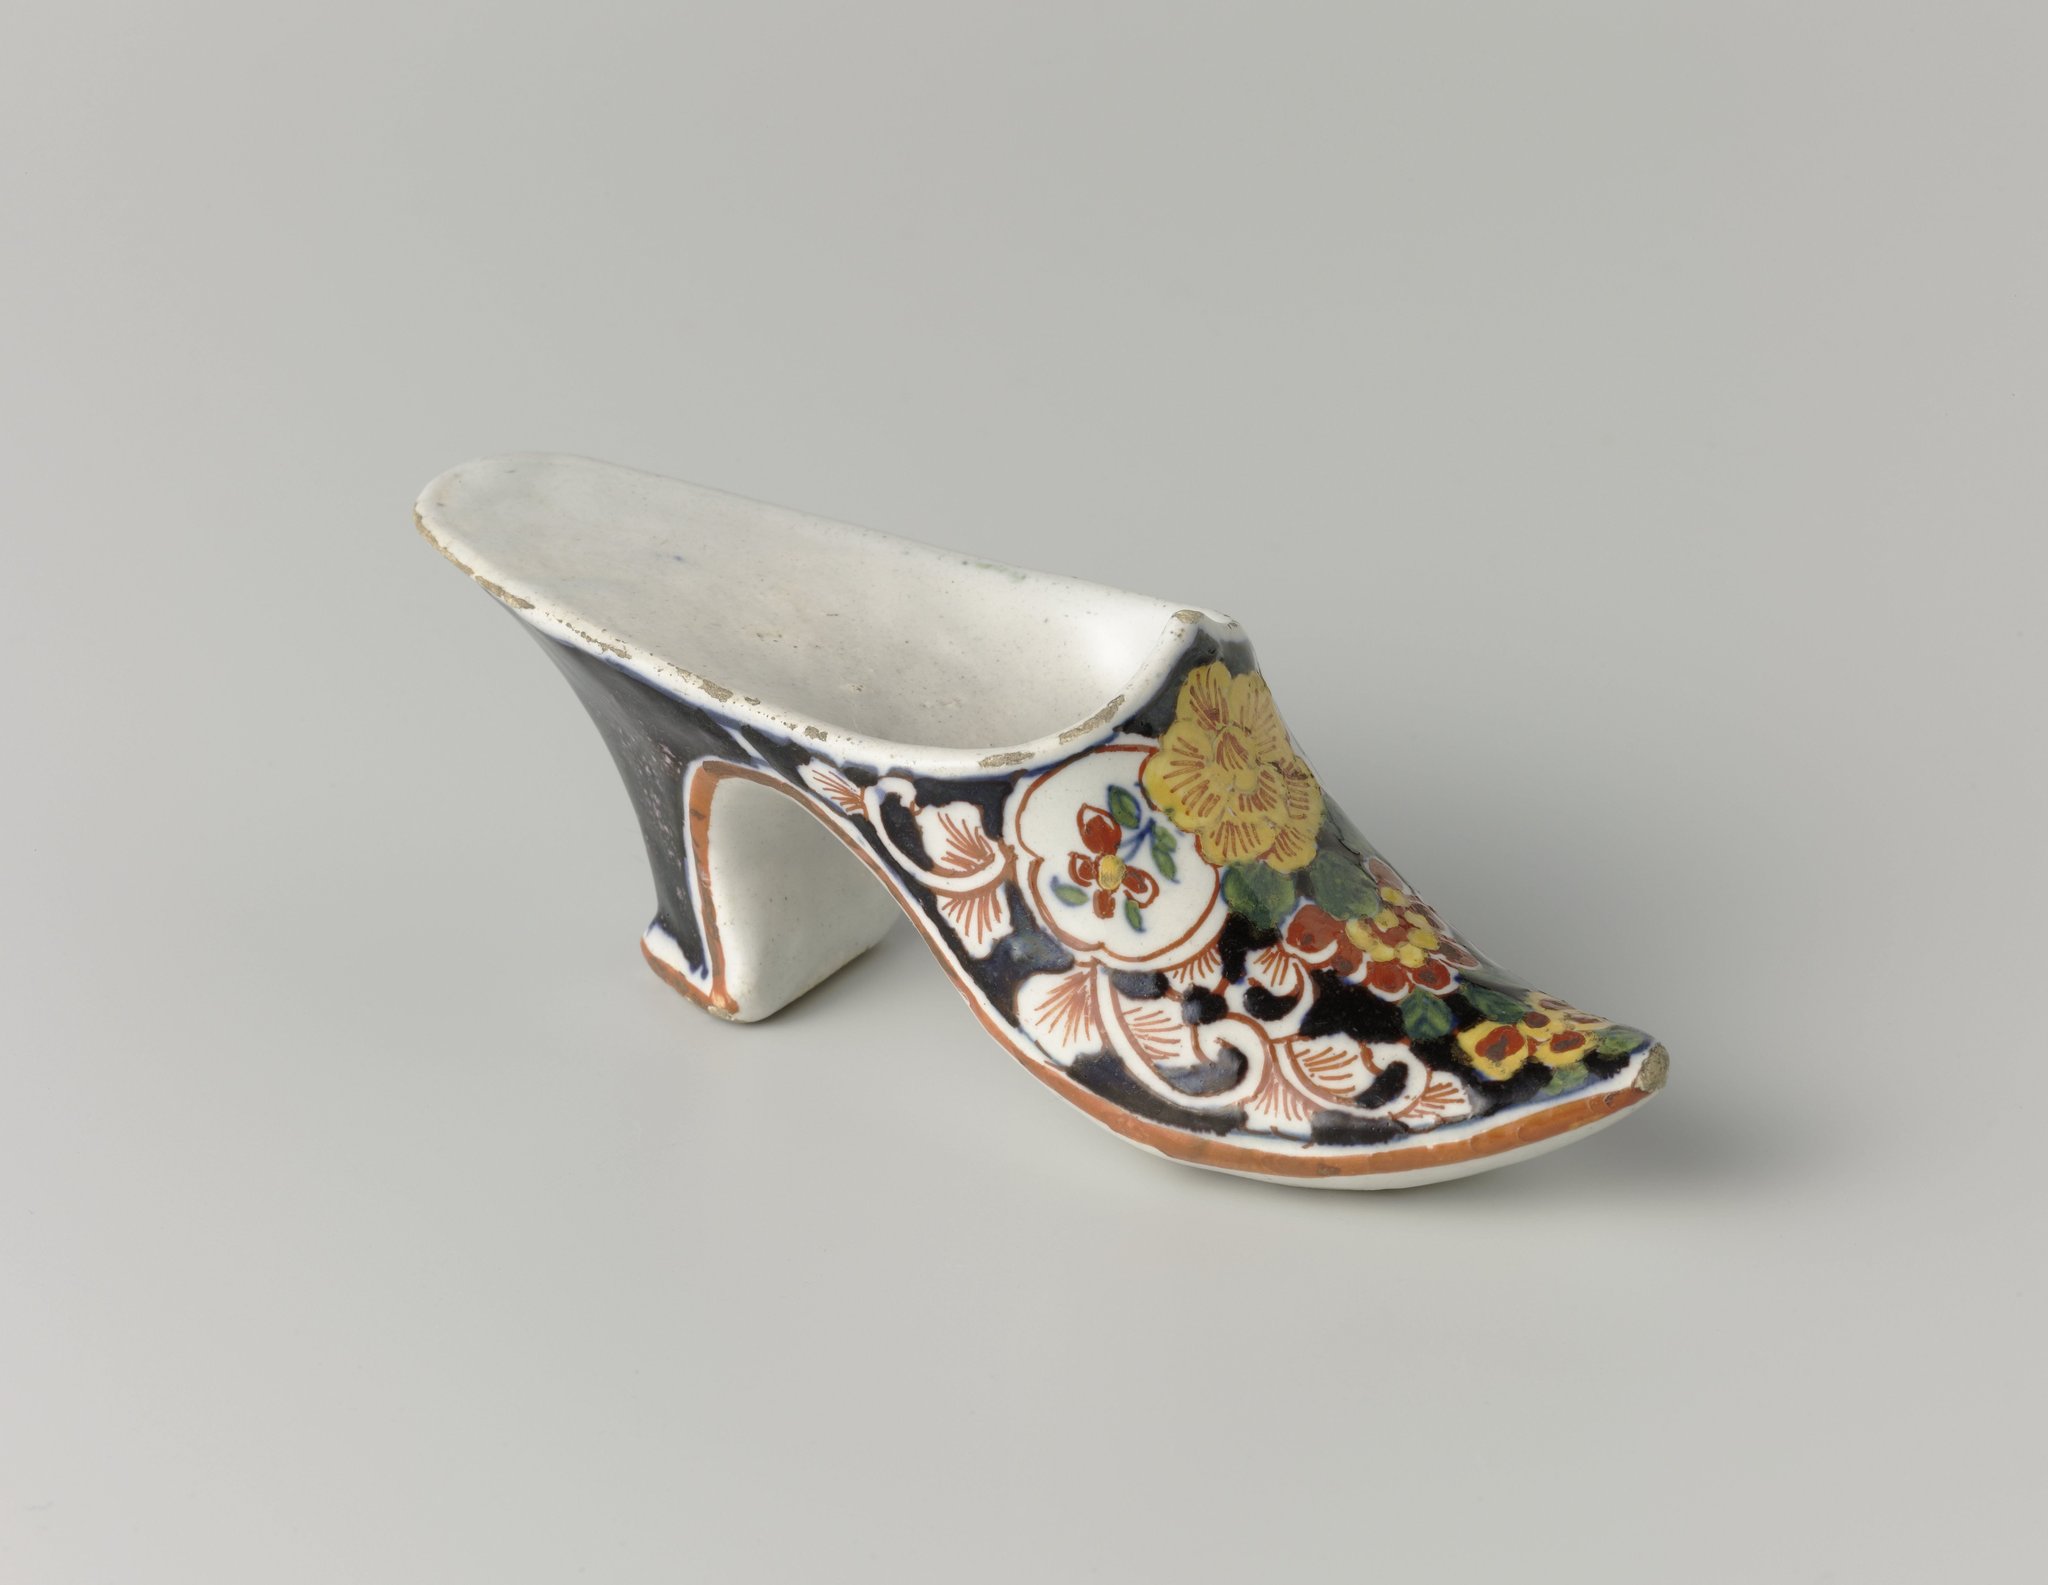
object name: decoratief object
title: Muiltje van faience, veelkleurig beschilderd met bloemen op een zwarte grond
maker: Anonymous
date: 1700-1730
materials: faience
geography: delft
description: Muiltje van faience. Veelkleurig beschilderd met bloemen op een zwarte grond.